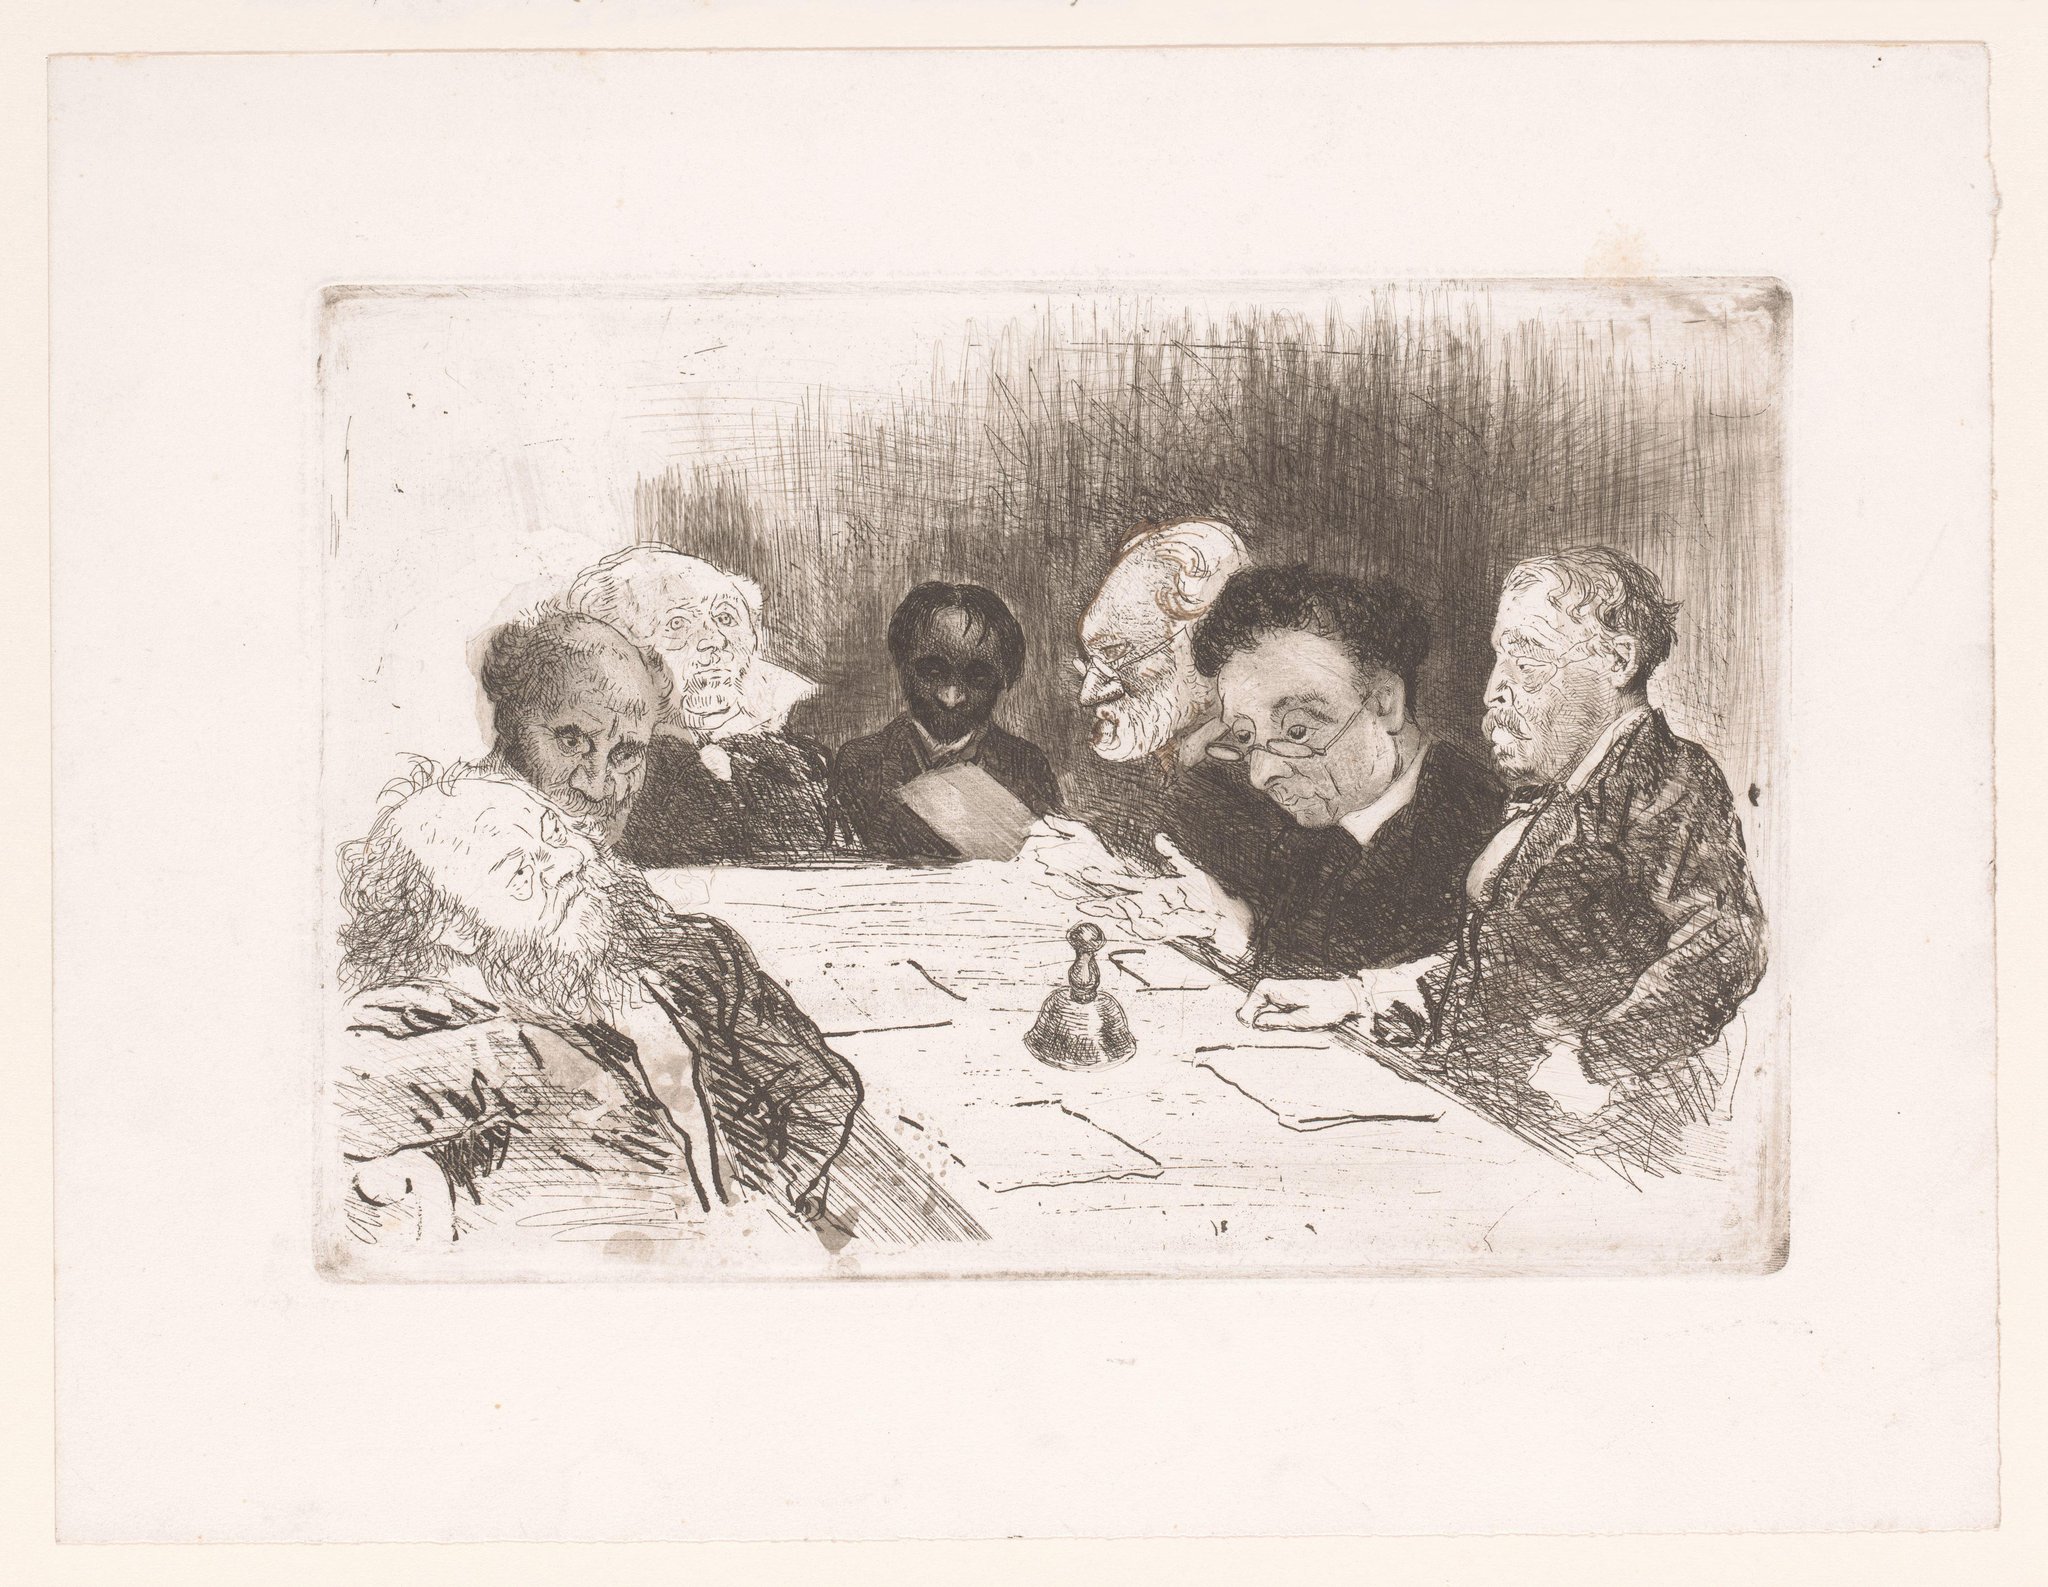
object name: print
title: Commissie voor reorganisatie van de Antwerpse Academie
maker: charles verlat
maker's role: painter, print maker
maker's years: 1824-1890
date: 1879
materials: paper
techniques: aquatint, drypoint, etching, retroussage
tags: antwerp, victor lagye, ghent, painter, théodore joseph canneel, print maker, charles verlat, societies and directory boards, historical persons, academy, association of artists, place or institution of education and training of the artist, e.g.: academy of art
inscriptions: collector's mark: Lugt 2228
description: De achternamen van de geportretteerden zijn (behalve bij de eerste staat) op de prent vermeld. Bij de meesten is het duidelijk om welke persoon het gaat, echter bij Winter, de Laye en Wagner is dit nog niet het geval.